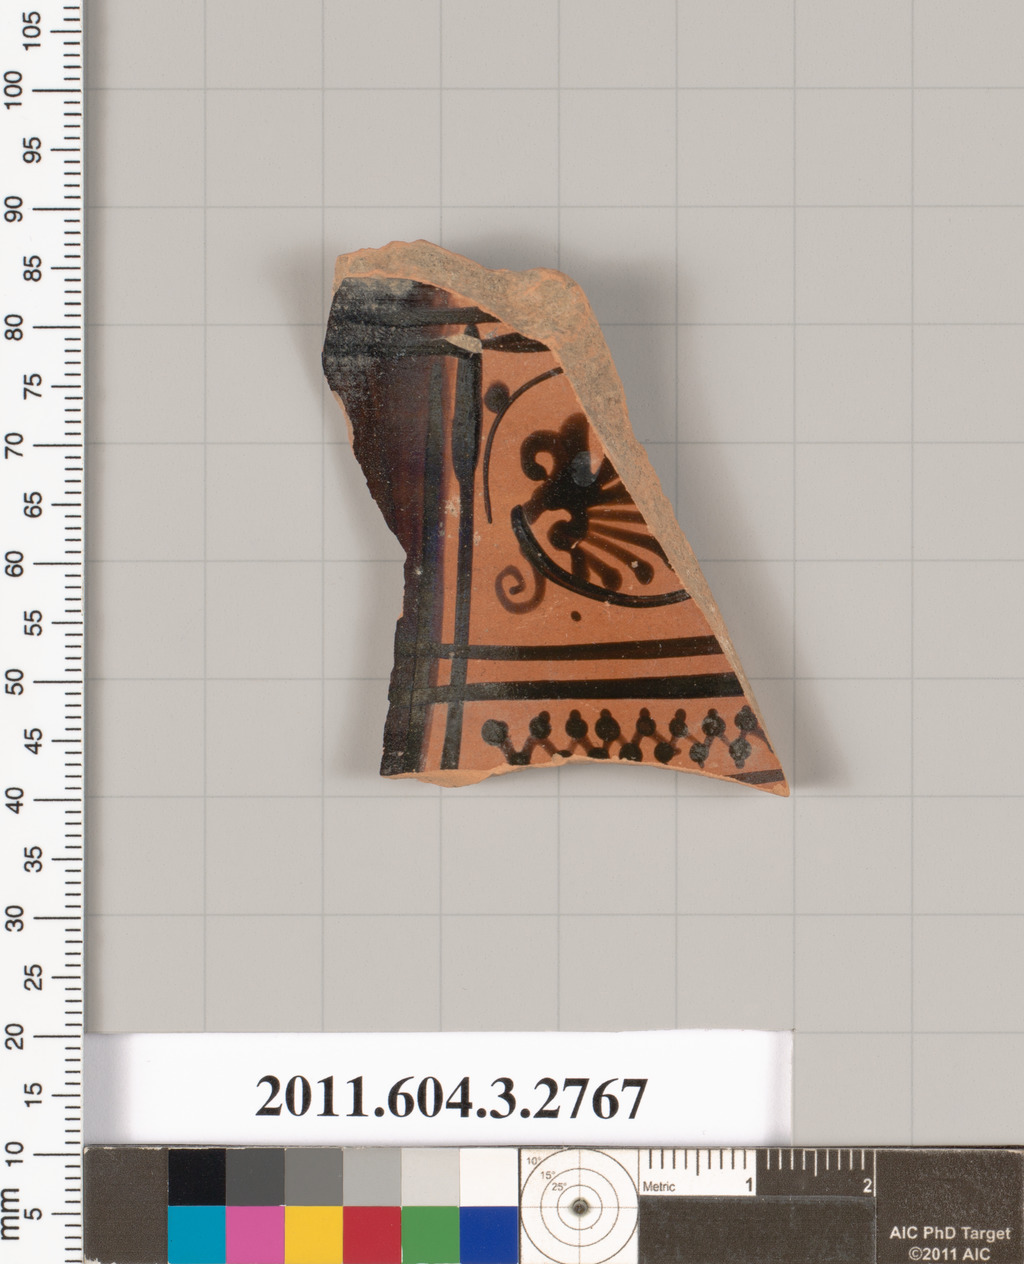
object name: olpe fragment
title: Terracotta fragment of an olpe (jug)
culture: greek, attic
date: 525-501 BCE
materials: terracotta